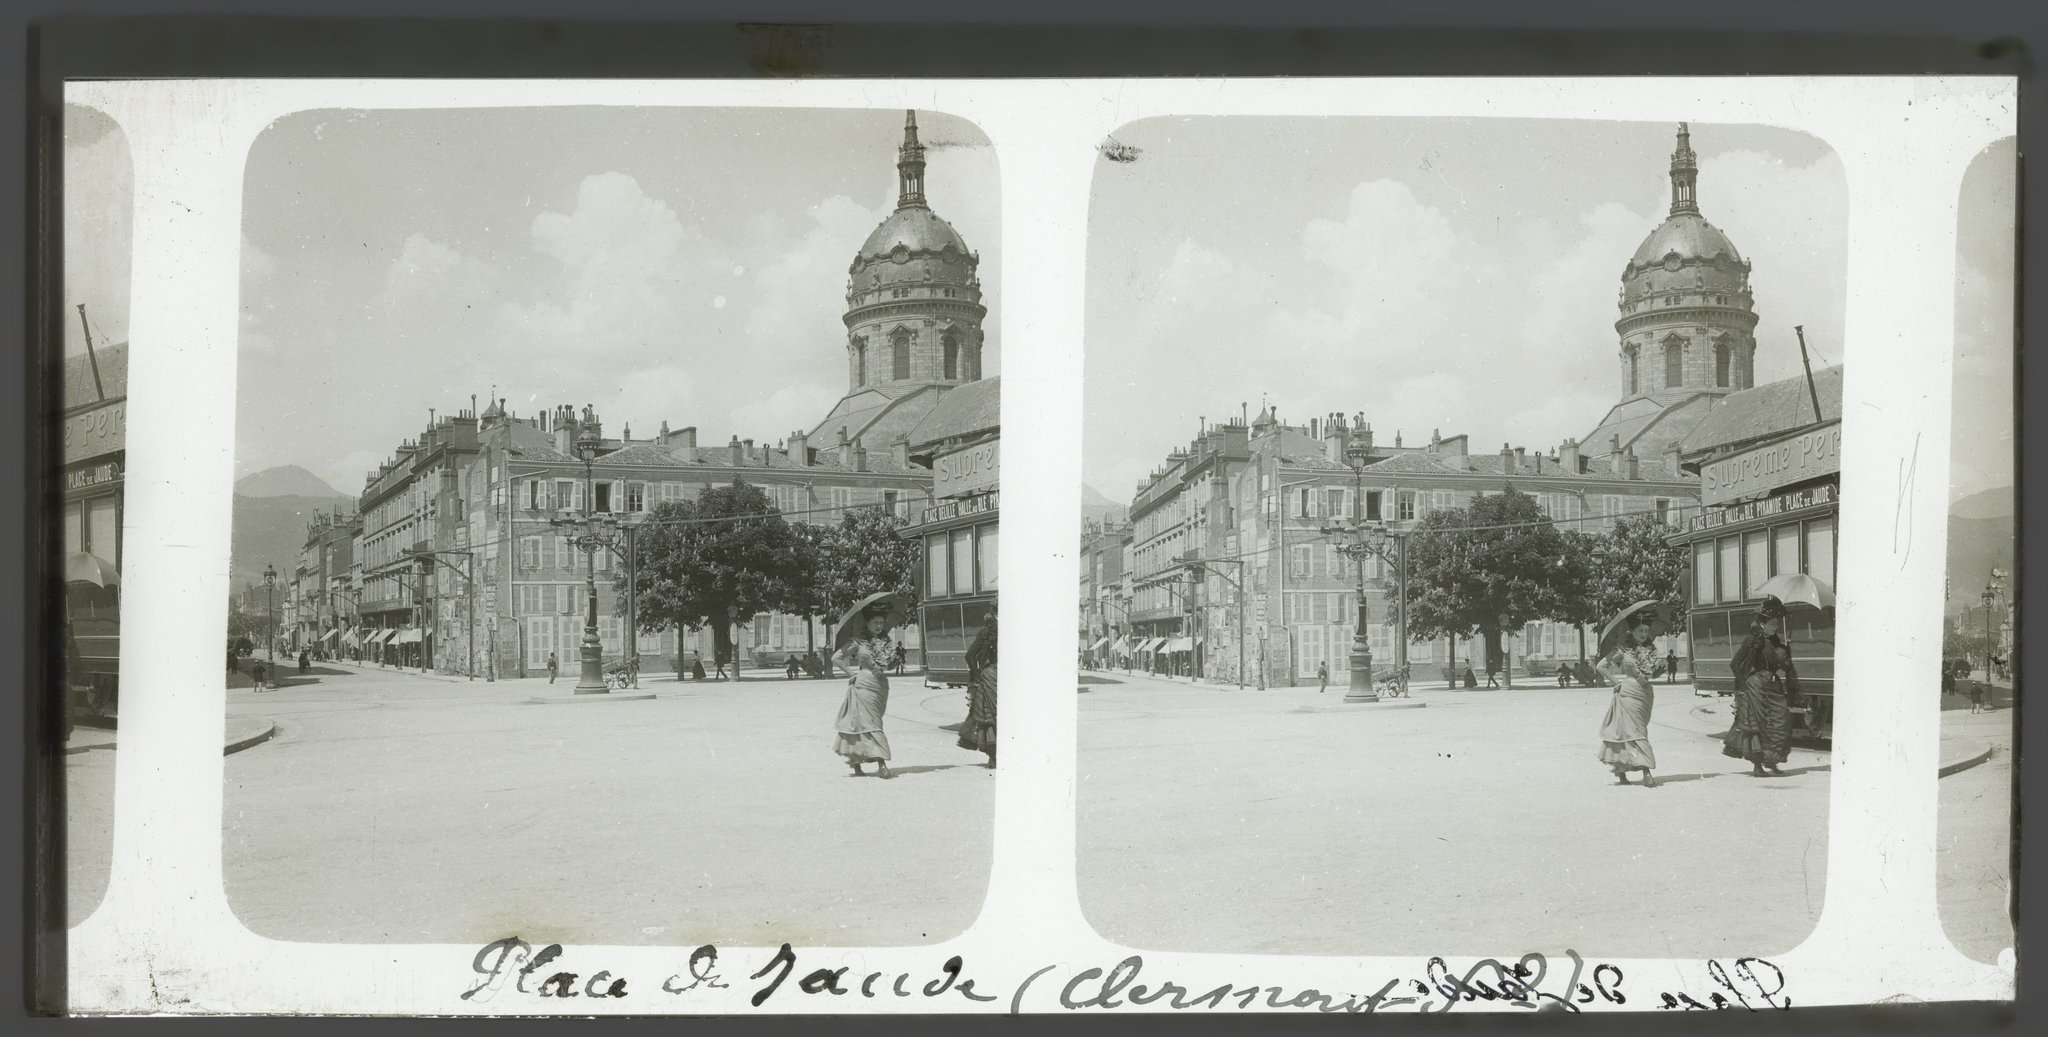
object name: stereoscopic photograph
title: Place de Jaude (Clermont-Fd)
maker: Anonymous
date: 1890-1910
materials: glass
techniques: slide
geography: clermont-ferrand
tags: square, place, circus, etc., tramway, tram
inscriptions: inscription: ‘Place de Jaude’